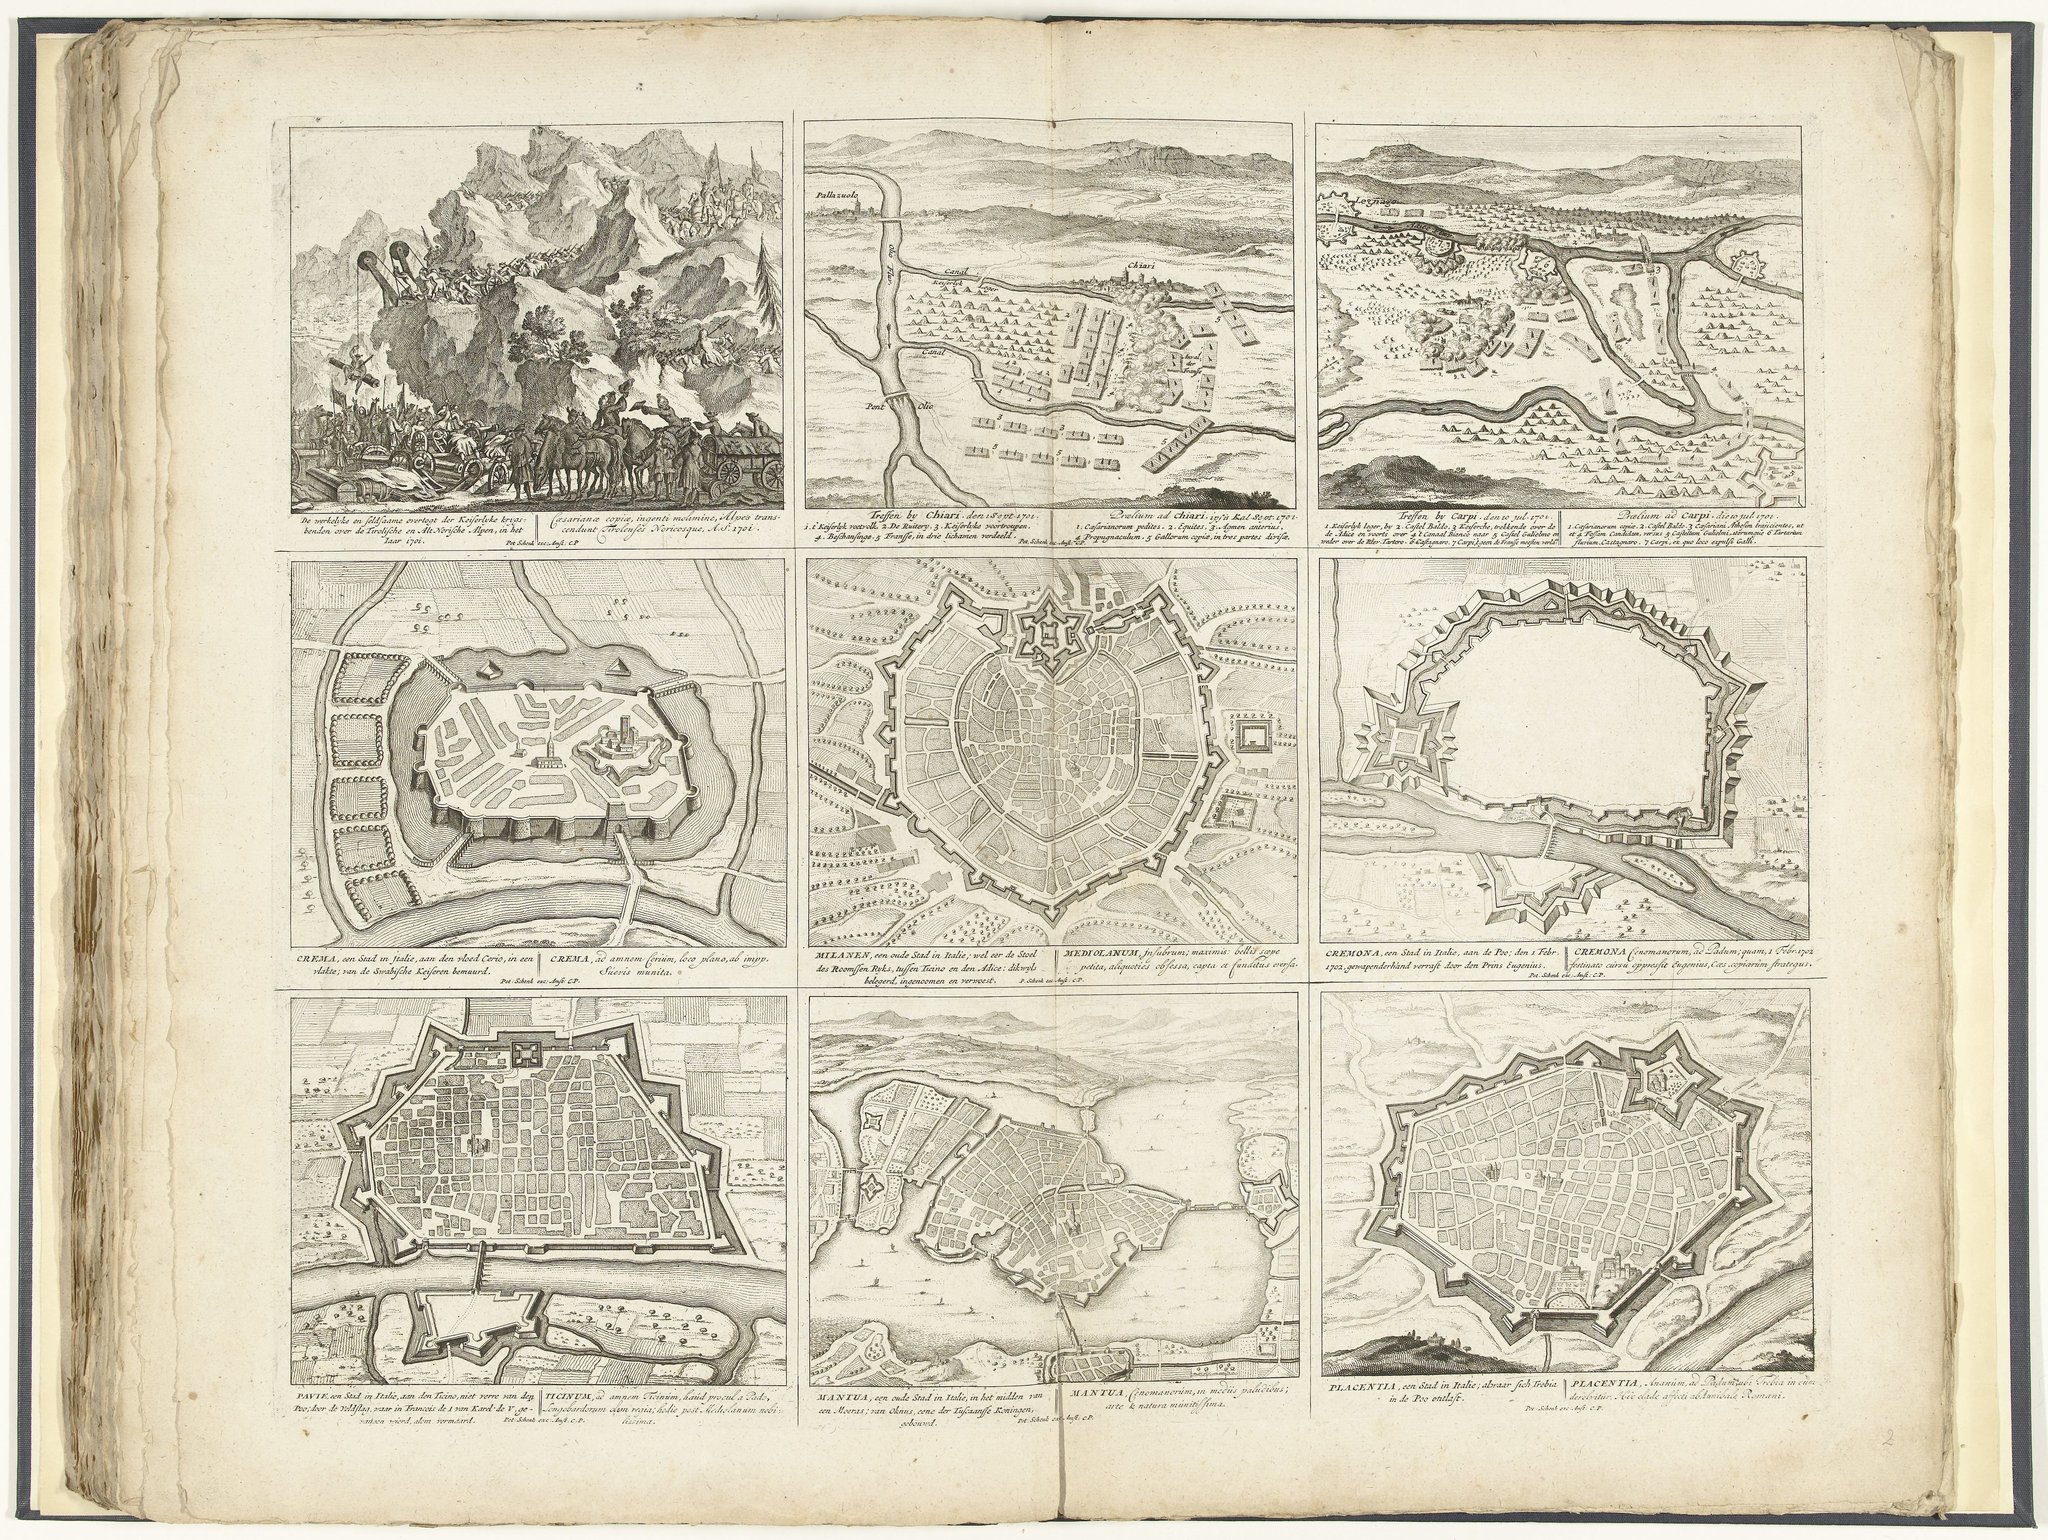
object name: print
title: Schouwtoneel van den Oorlog Beginnende met Koning Karel den tweeden Bestaande in Veldslagen, en Belegeringen, Zoo te Water als te Lande, met de voornaamste Vestingen (...)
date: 1702-1706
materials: paper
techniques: etching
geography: northern netherlands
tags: fortress, maps of cities, battle (+ land forces)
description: Blad met negen voorstellingen van gebeurtenissen uit de jaren 1701-1702 van de Spaanse Successieoorlog. Opschriften in de voorstelling in het Nederlands en Latijn. Plaat 27 in het prentwerk met de gebundelde reeks van 33 platen met voorstellingen (het merendeel verdeeld in 9 kleinere scènes) van gebeurtenissen uit de jaren 1700-1727 van de Spaanse Successieoorlog en de jaren daarna, kaarten en plattegronden.